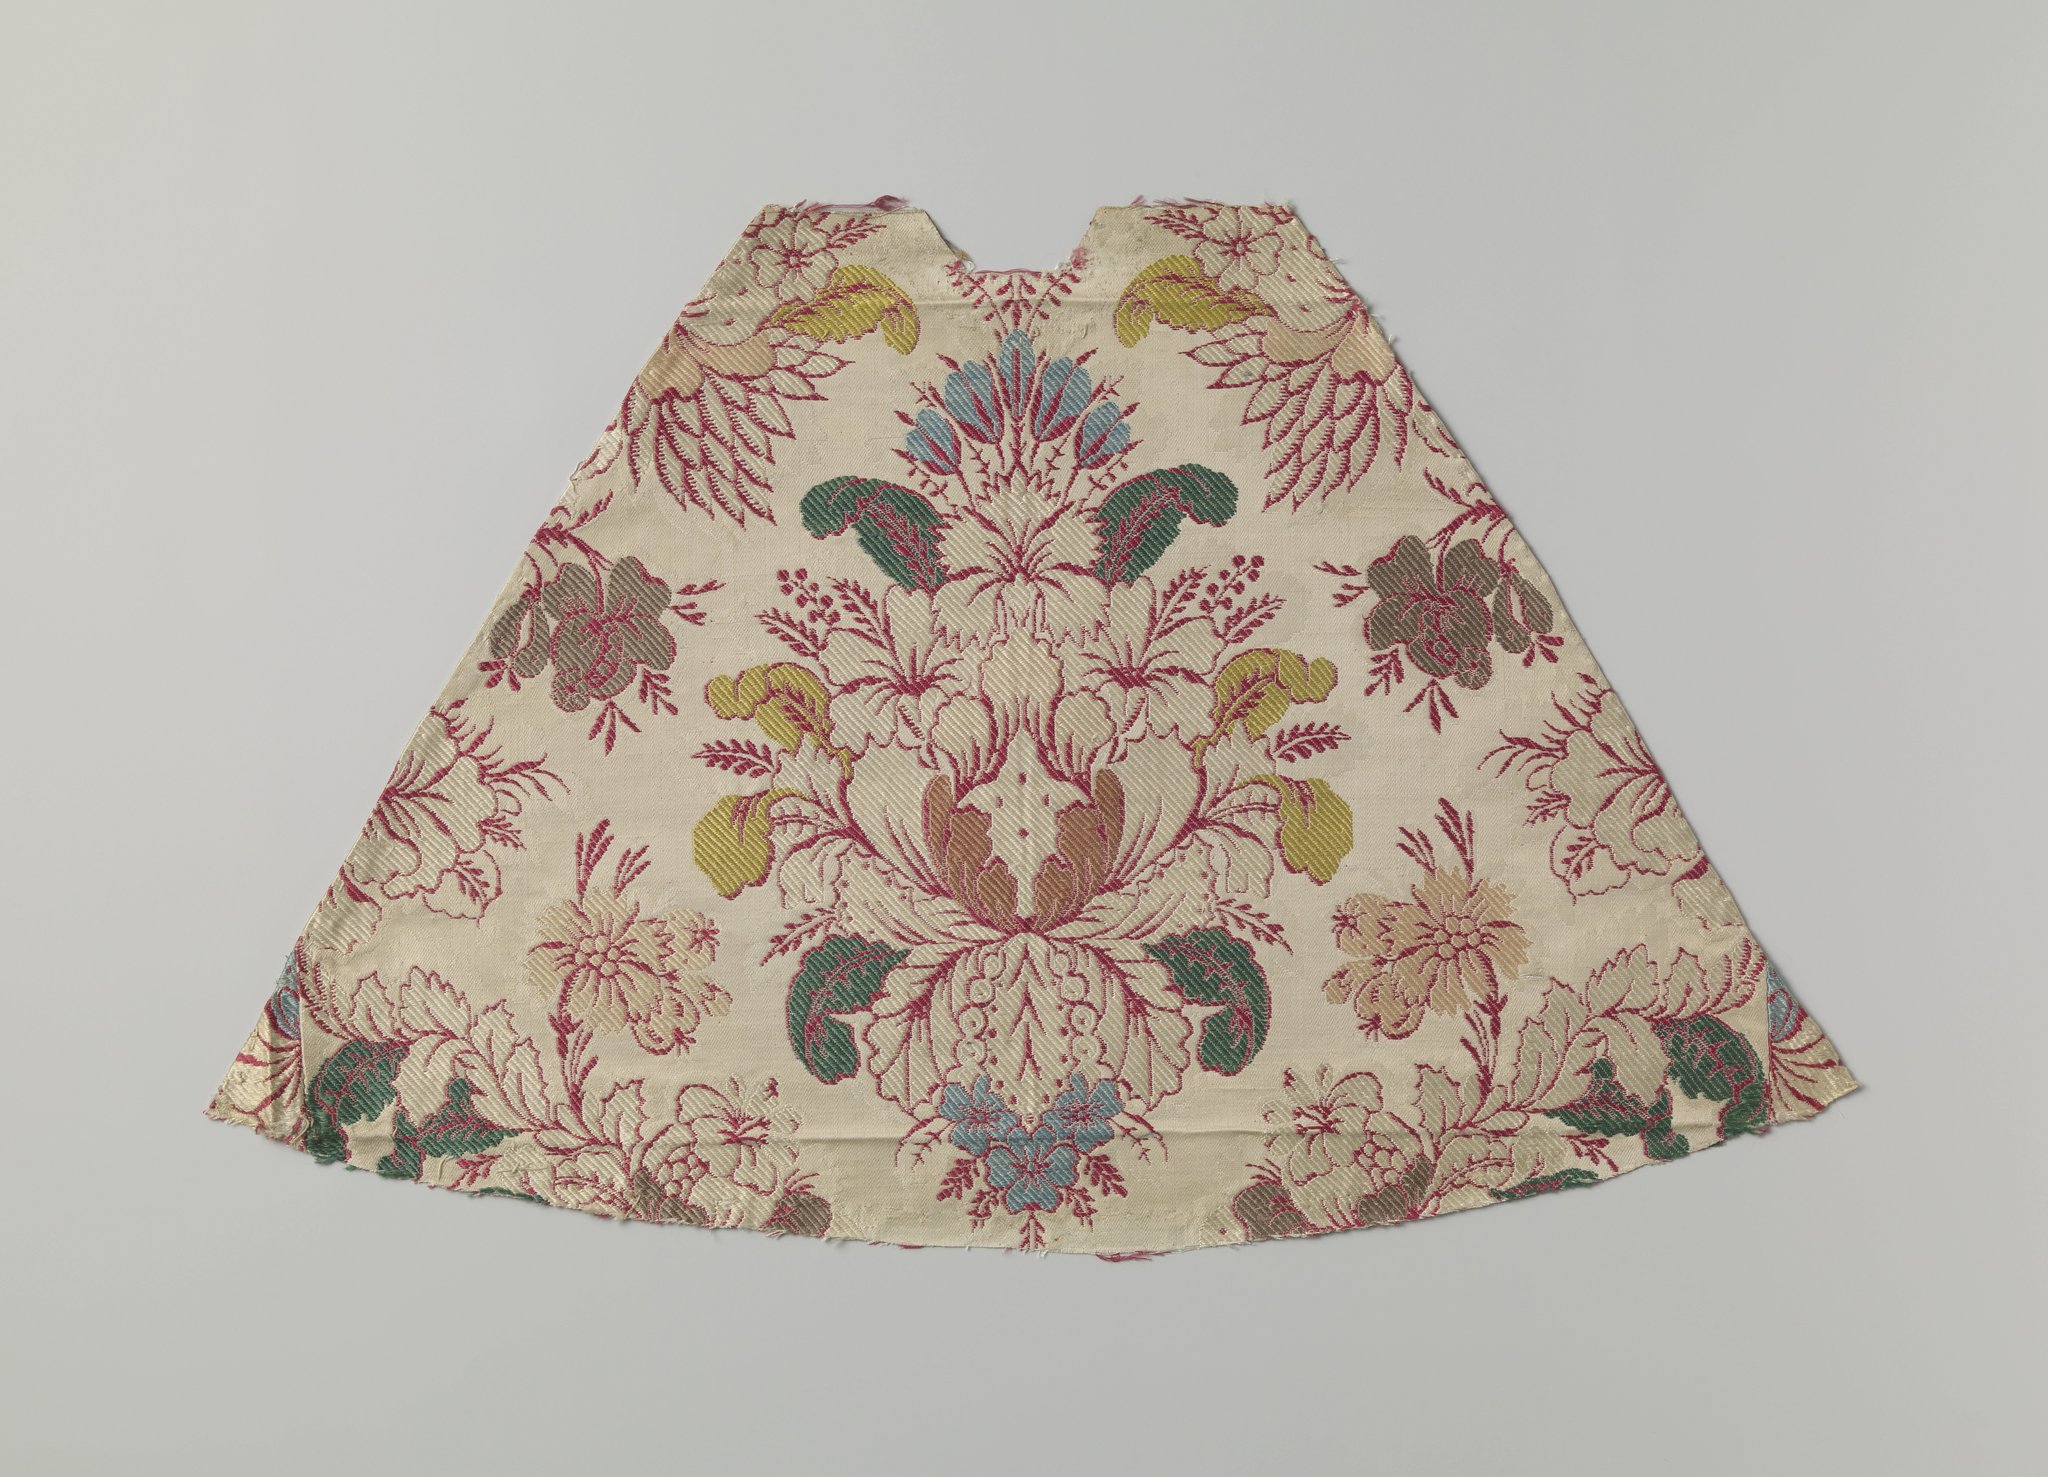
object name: fragment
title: Fragment veelkleurig zijdelampas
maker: Anonymous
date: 1680-1750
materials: silk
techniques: brocade, lampas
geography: france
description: Fragment veelkleurig zijdeweefsel, met een witte grond waarop een patroon van bloemtakken rond een bloemboeket.